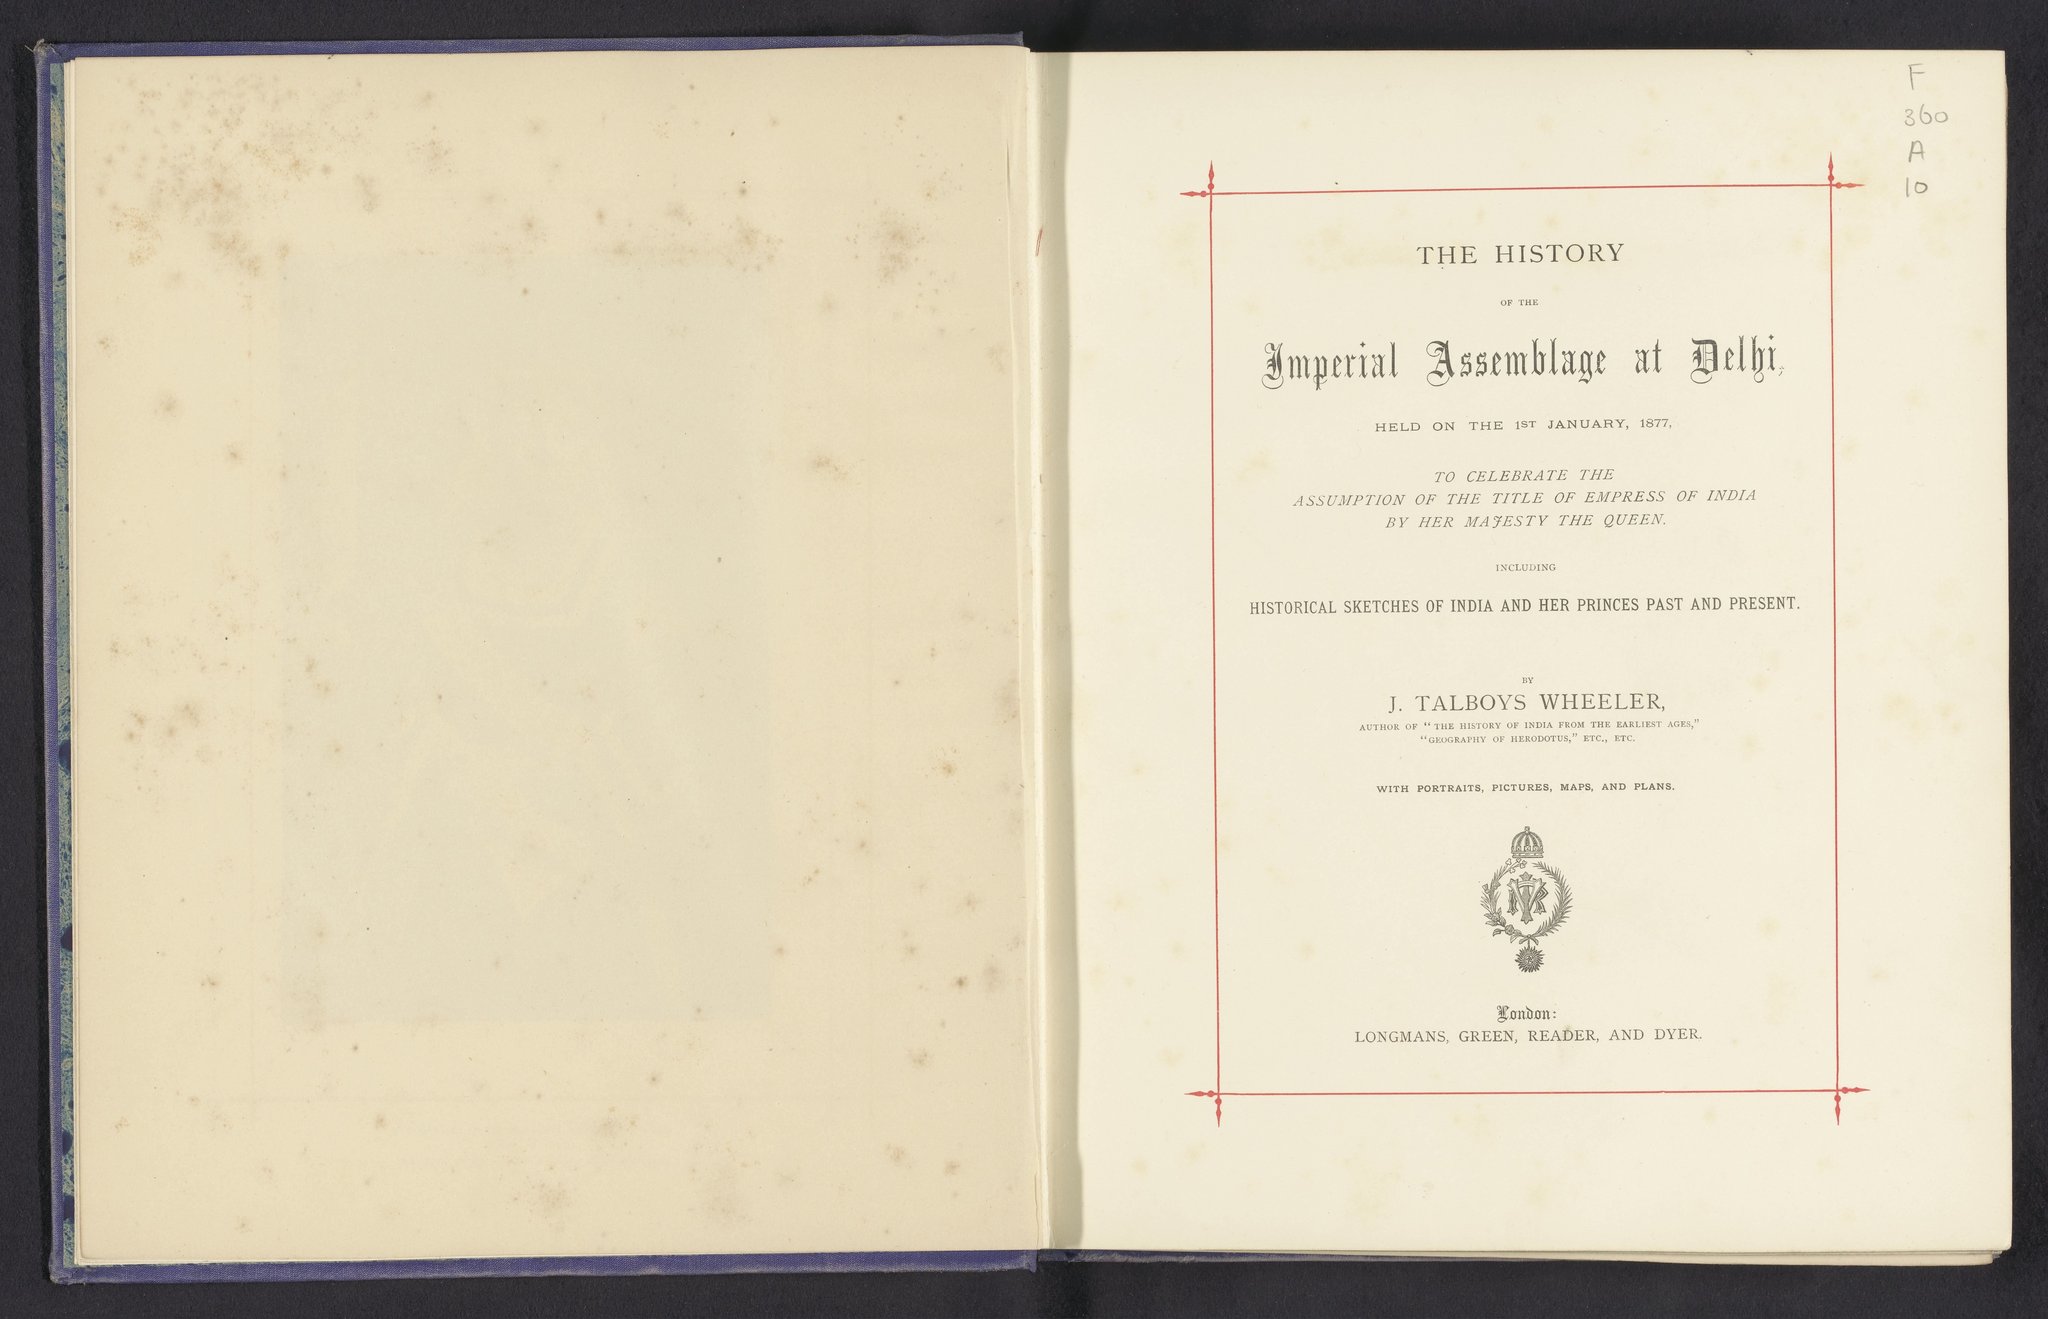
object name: book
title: The history of the Imperial Assemblage at Delhi held on the 1st January, 1877, to celebrate the assumption of the title of Empress of India by Her Majesty the Queen including historical sketches of India and her princes past and present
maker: james talboys wheeler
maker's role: historicus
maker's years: 1824-1897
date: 1877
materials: paper, photographic support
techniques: albumen print, marbling, printing, woodburytype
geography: london